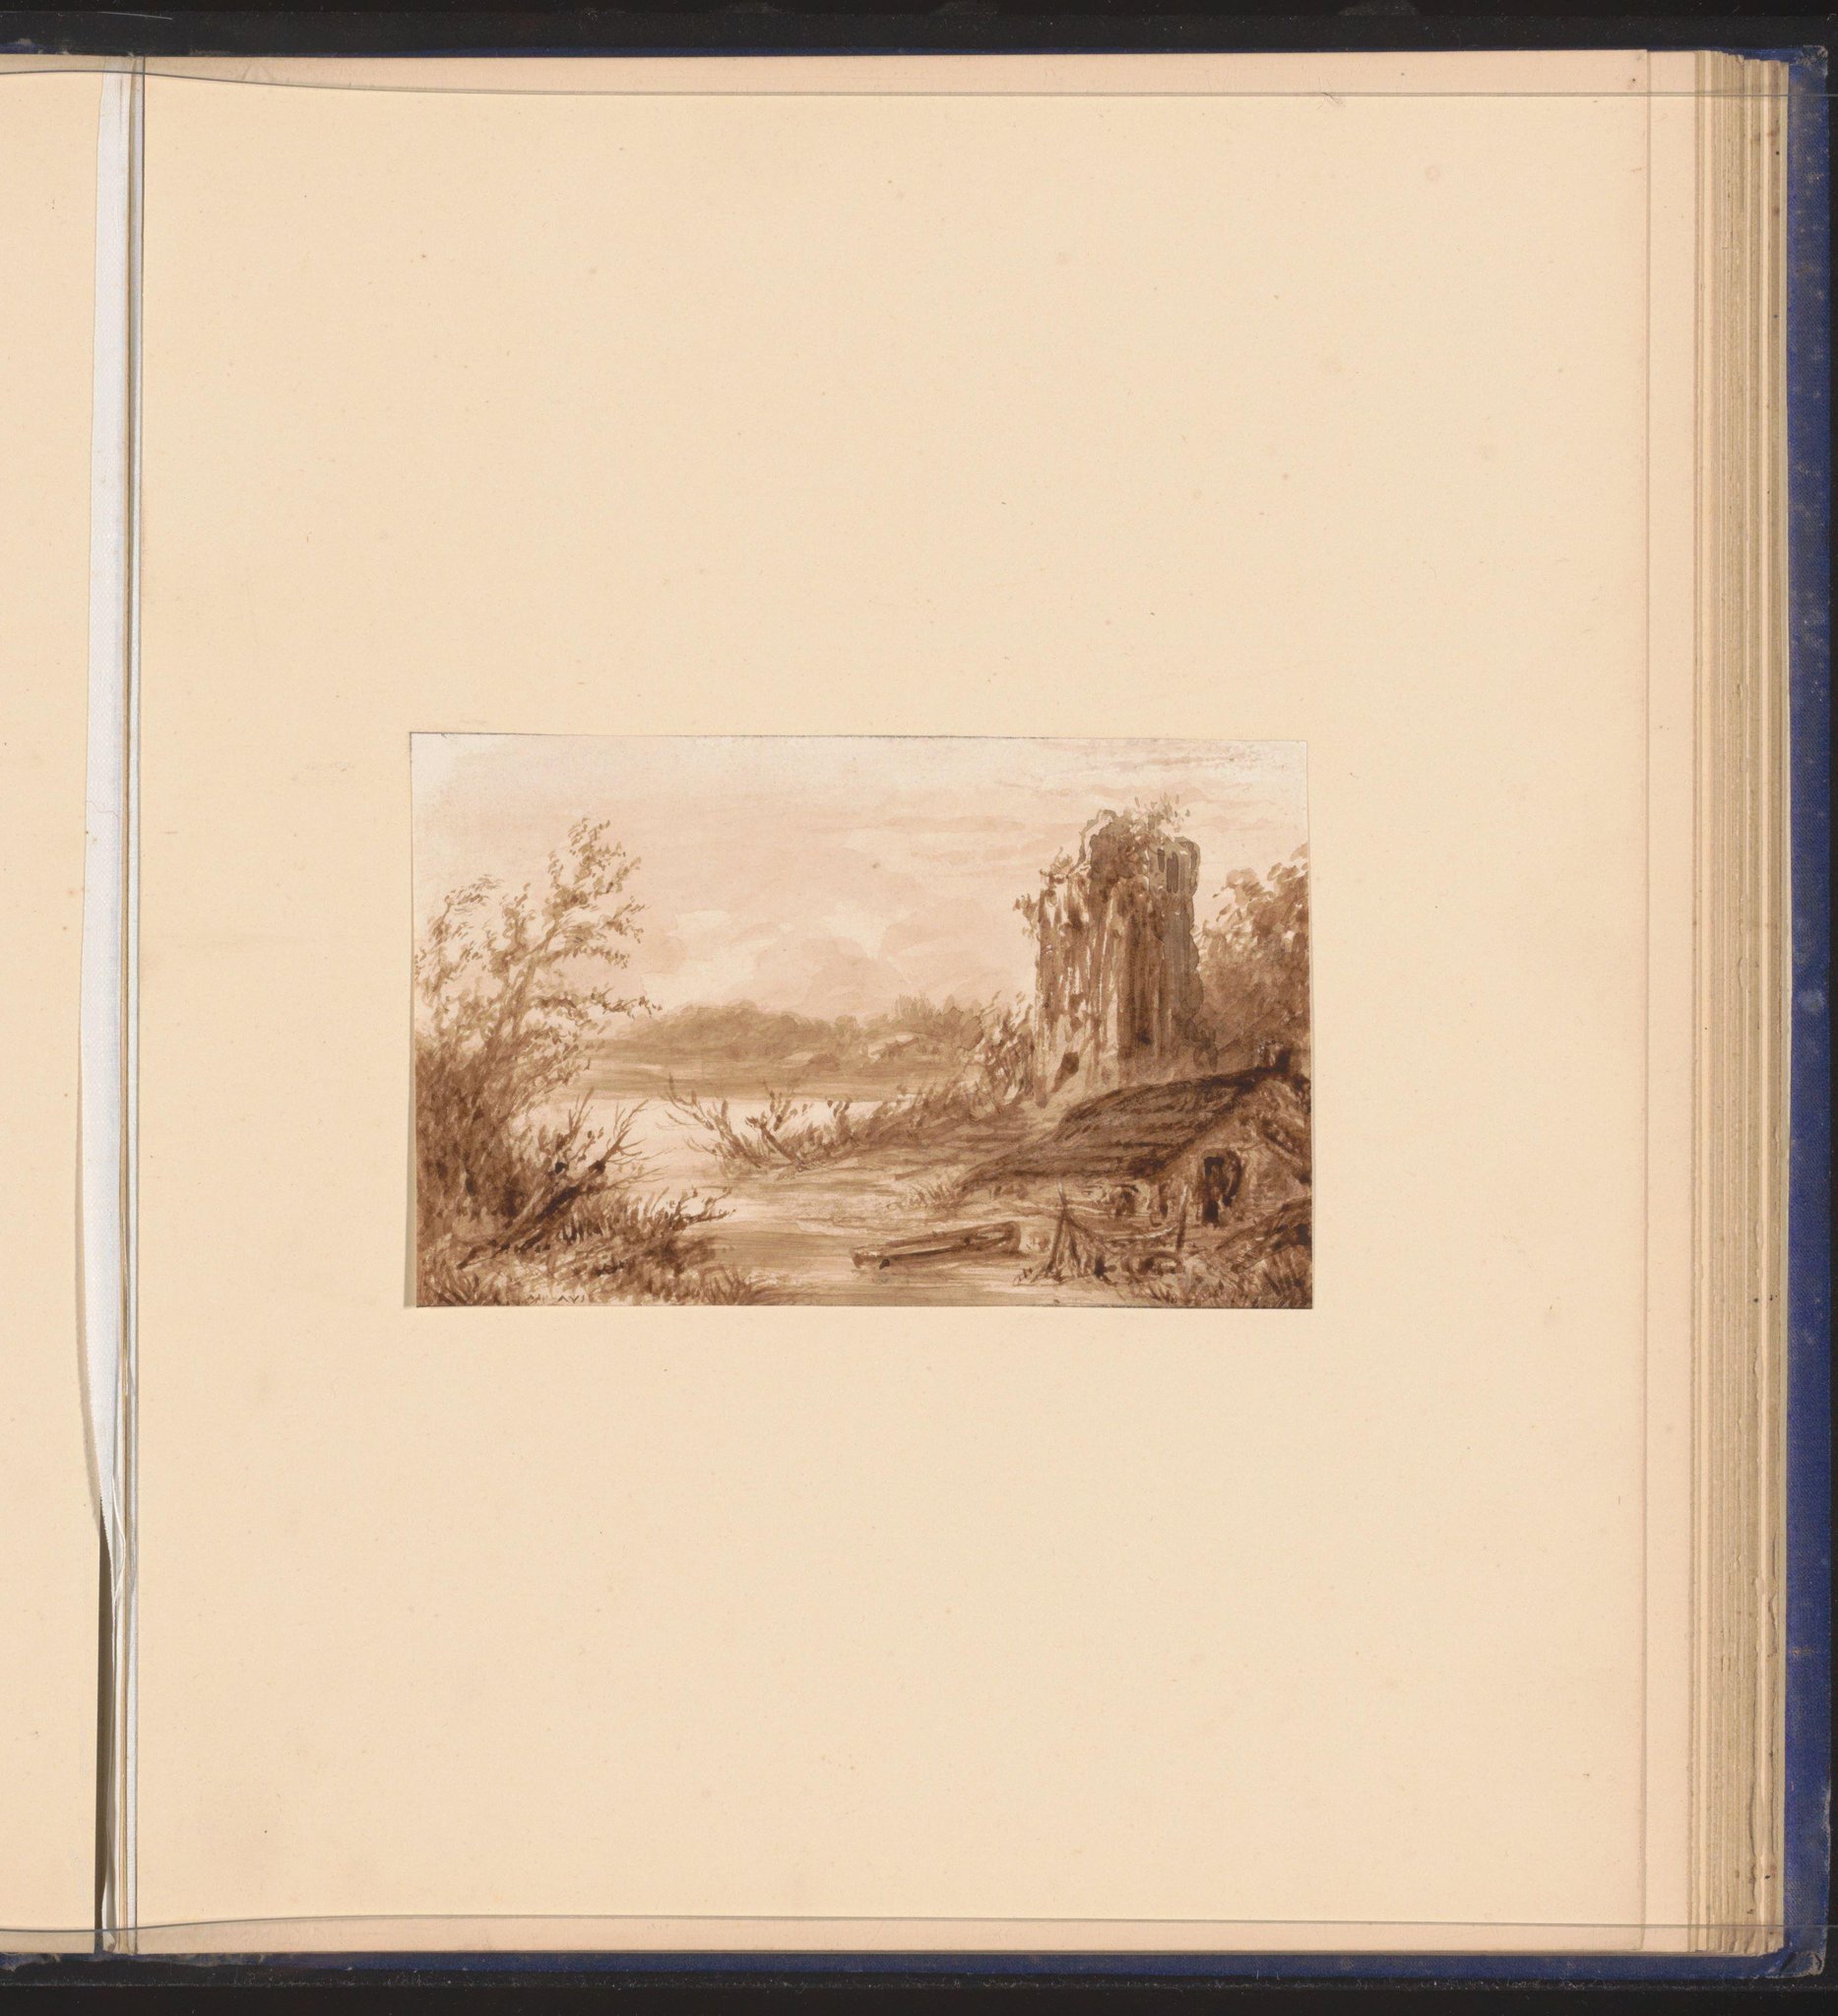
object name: album leaf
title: Boerderij aan een waterkant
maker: alexander ver huell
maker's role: draughtsman, print maker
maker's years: 1822-1897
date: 1882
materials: paper, watercolor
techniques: brush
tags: landscapes with waters, waterscapes, seascapes (in the temperate zone), rowing-boat, canoe, etc., farm or solitary house in landscape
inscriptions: signature: ‘AVH’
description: Langs de waterkant ligt een roeiboot aangemeerd. Op de achtergrond de ruïne van een toren. Tekening op blad 11 van een album met 24 ingeplakte schetsen.